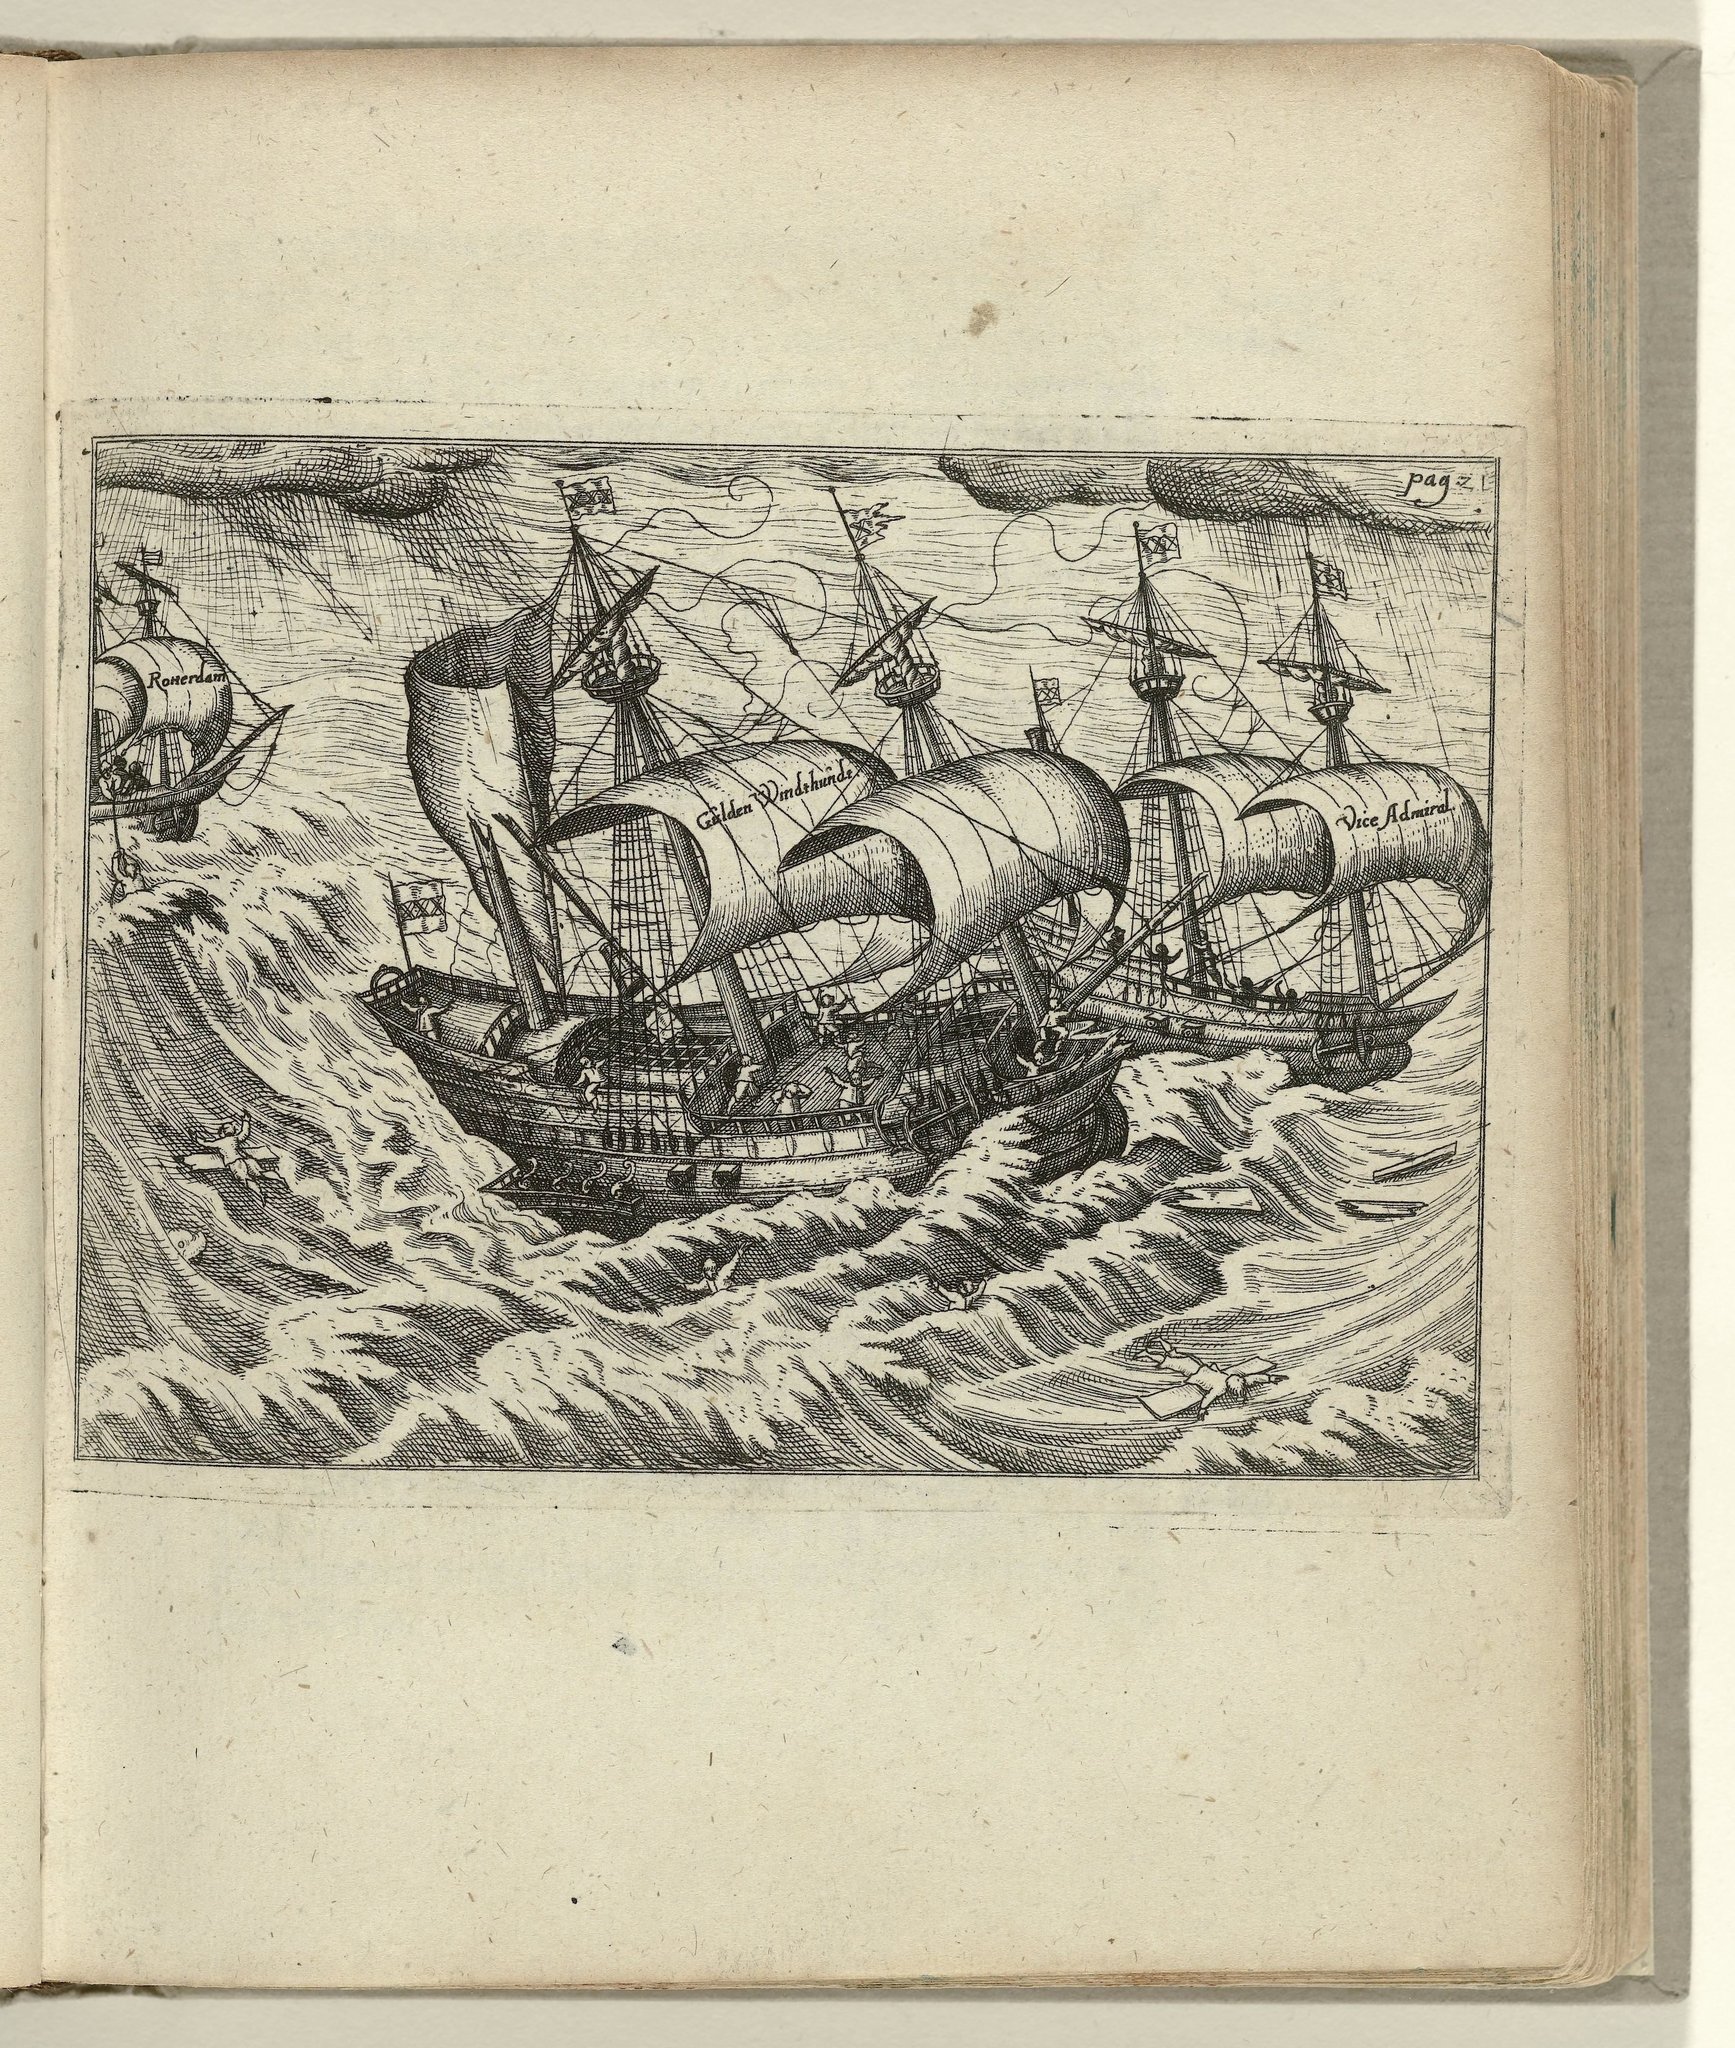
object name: print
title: Aanvaring tussen de schepen van Barentsz en Van Linschoten, 1595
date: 1598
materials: paper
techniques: engraving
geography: nuremberg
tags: willem barendsz., amsterdam, jacob van heemskerck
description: In zwaar weer raken de schepen van Barentsz en Van Linschoten met elkaar in aanvaring tijdens de tweede reis, 6 augustus 1595. Tegenover pagina 21 in: 'Warhafftige Relation. Der dreyen newen unerhörten seltzamen Schiffart so die Holländischen und Seeländischen Schiff....Anno 1594, 1595 und 1596 verricht' (1598).